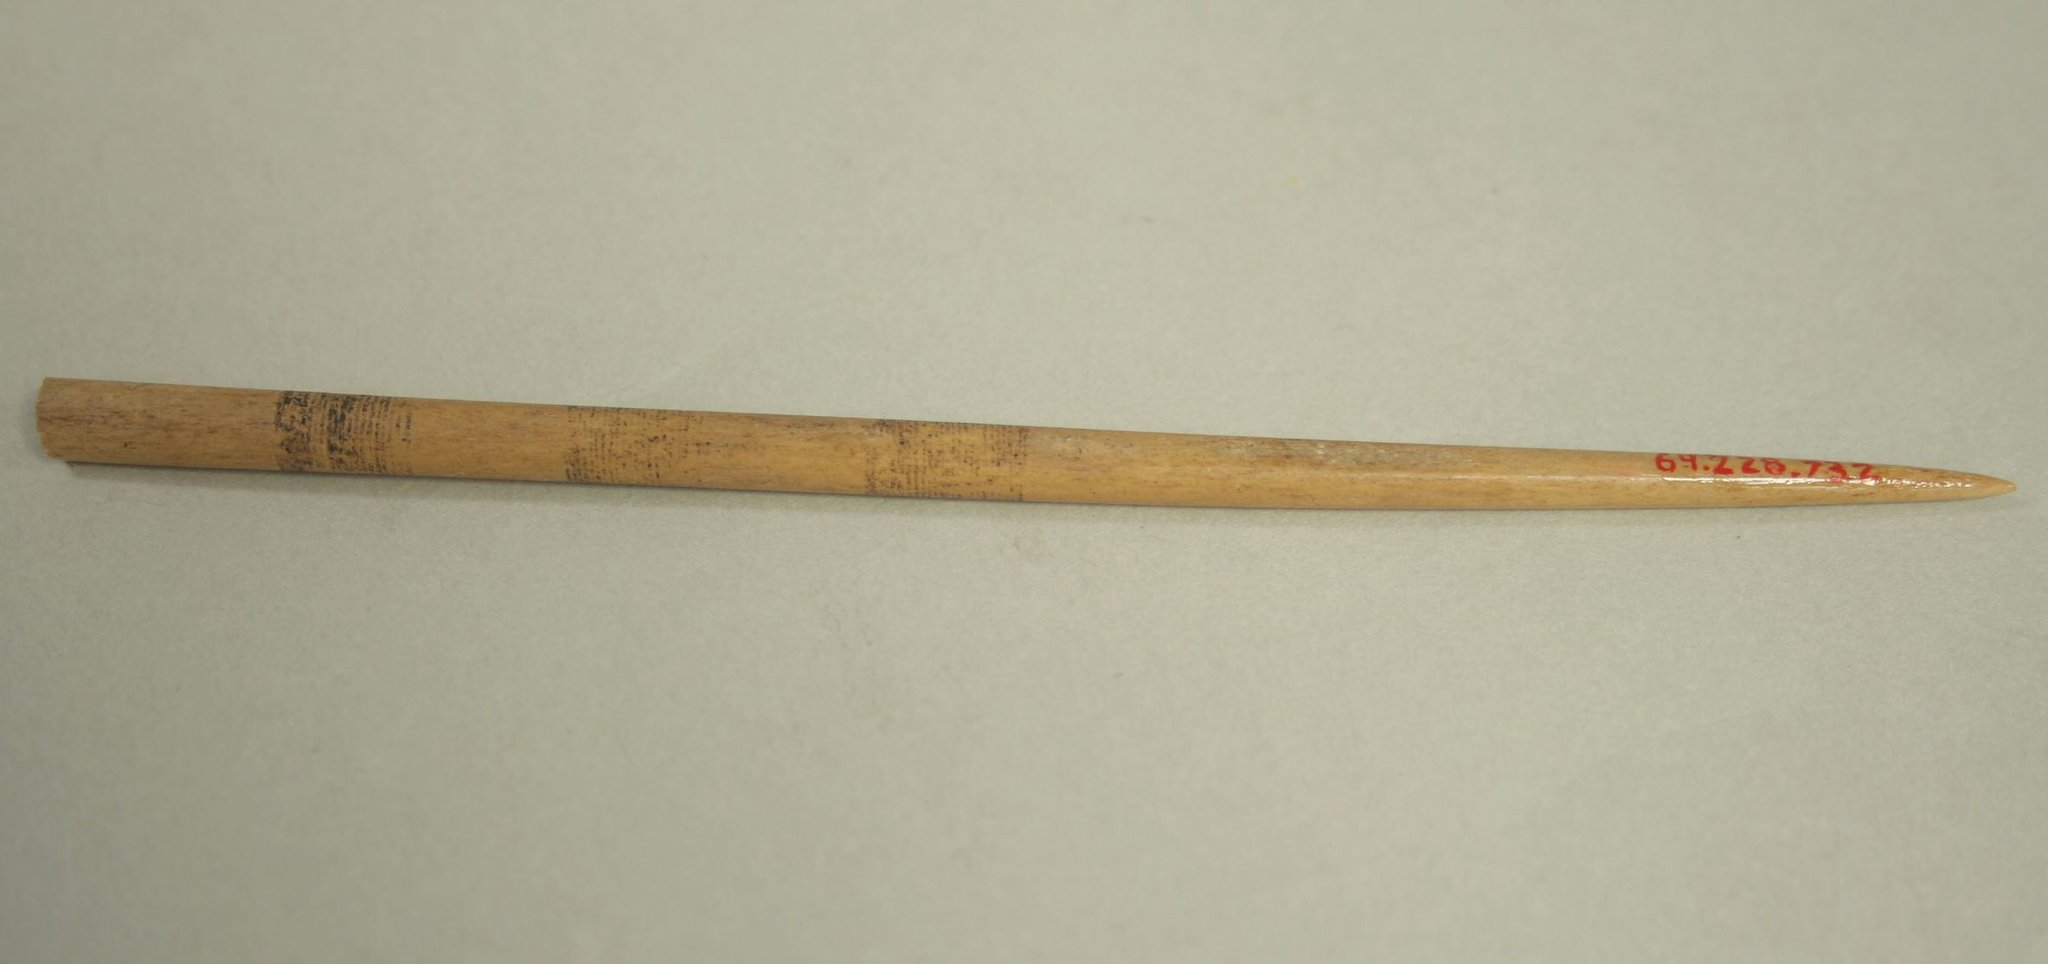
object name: bobbin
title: Bone Weaving Bobbin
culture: peruvian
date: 701-1566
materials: bone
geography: peru